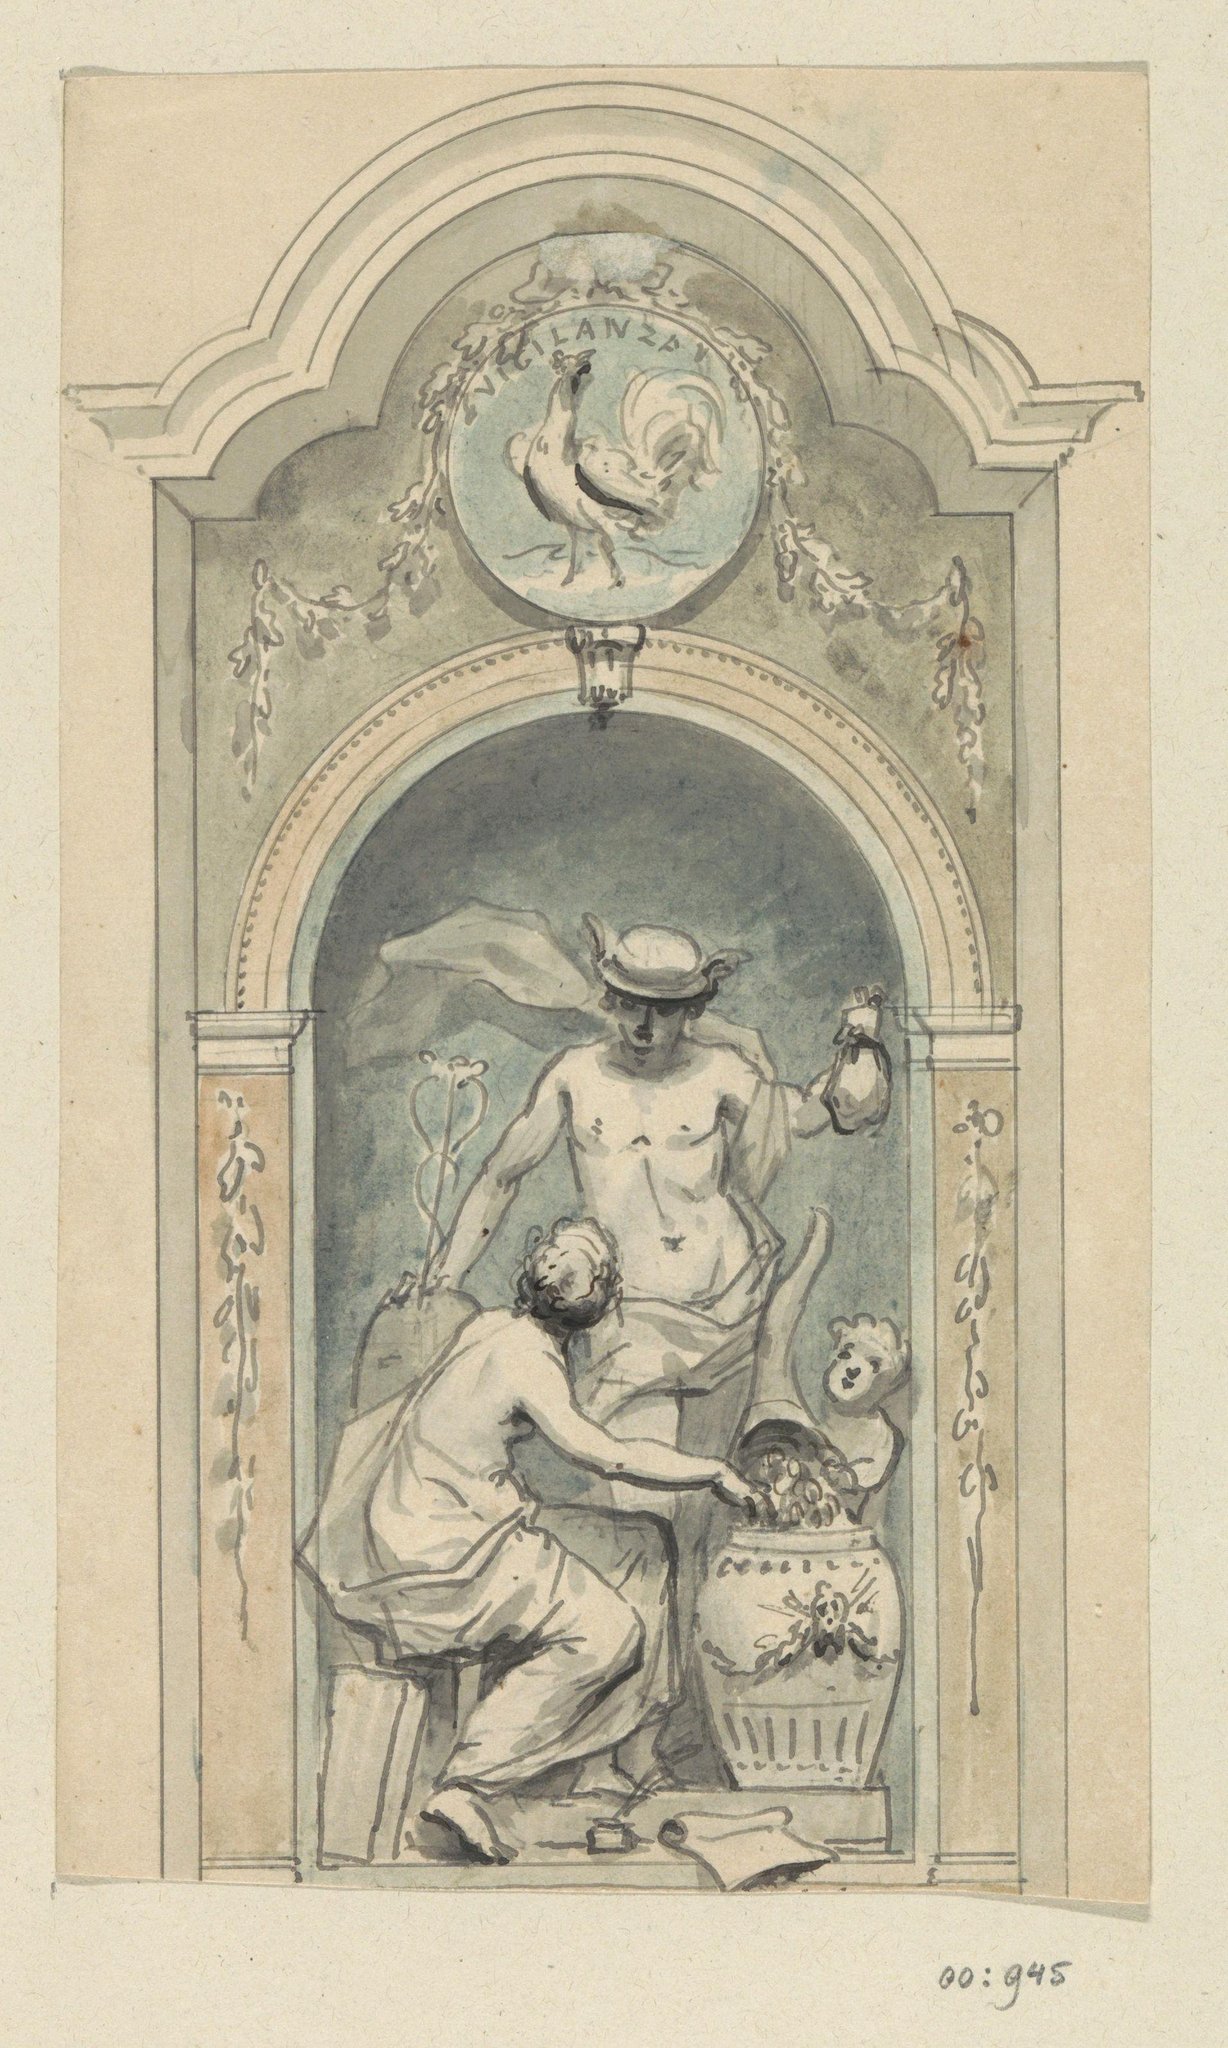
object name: drawing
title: Nis met een standbeeld van Handel met Mercurius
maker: jurriaan andriessen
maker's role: draughtsman, painter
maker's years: 1742-1819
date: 1760-1819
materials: paint, paper, pencil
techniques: brush, pen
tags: (story of) mercury (hermes), sculpture, allegory of trade; 'commertio della vita humana' (ripa)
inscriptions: inscription: ‘koophandel rustende op yver en verteld/ van wackerheyd brengt overvloed’